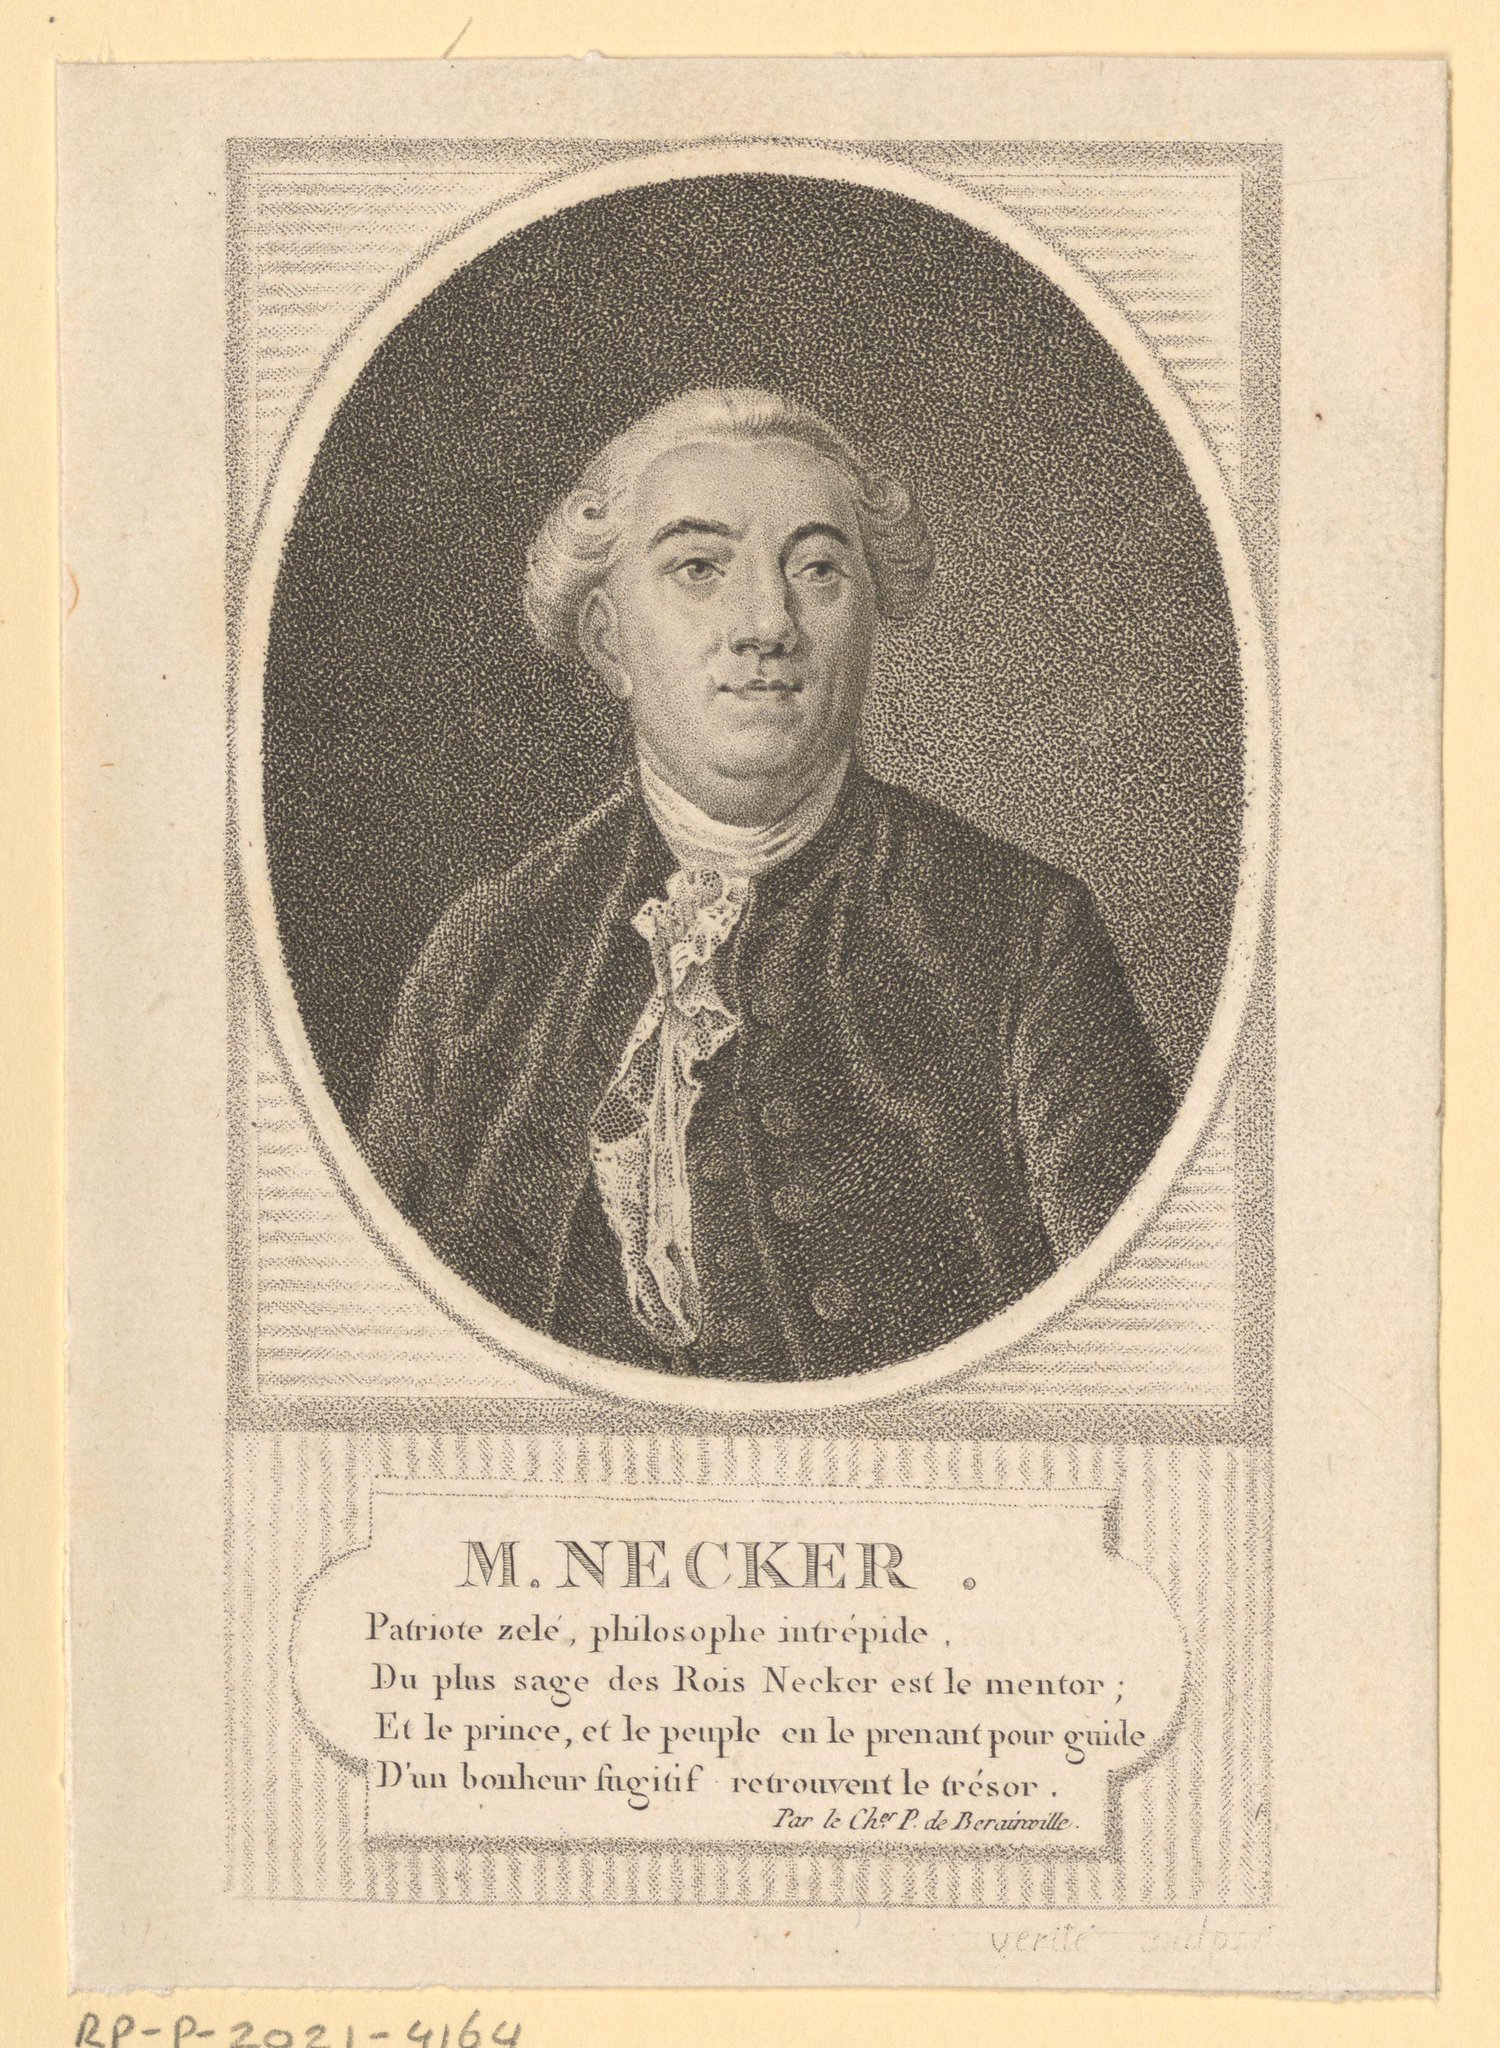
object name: print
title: Portret van Jacques Necker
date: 1788-1805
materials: paper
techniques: stippling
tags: official; civil servant; functionary (in general), historical persons